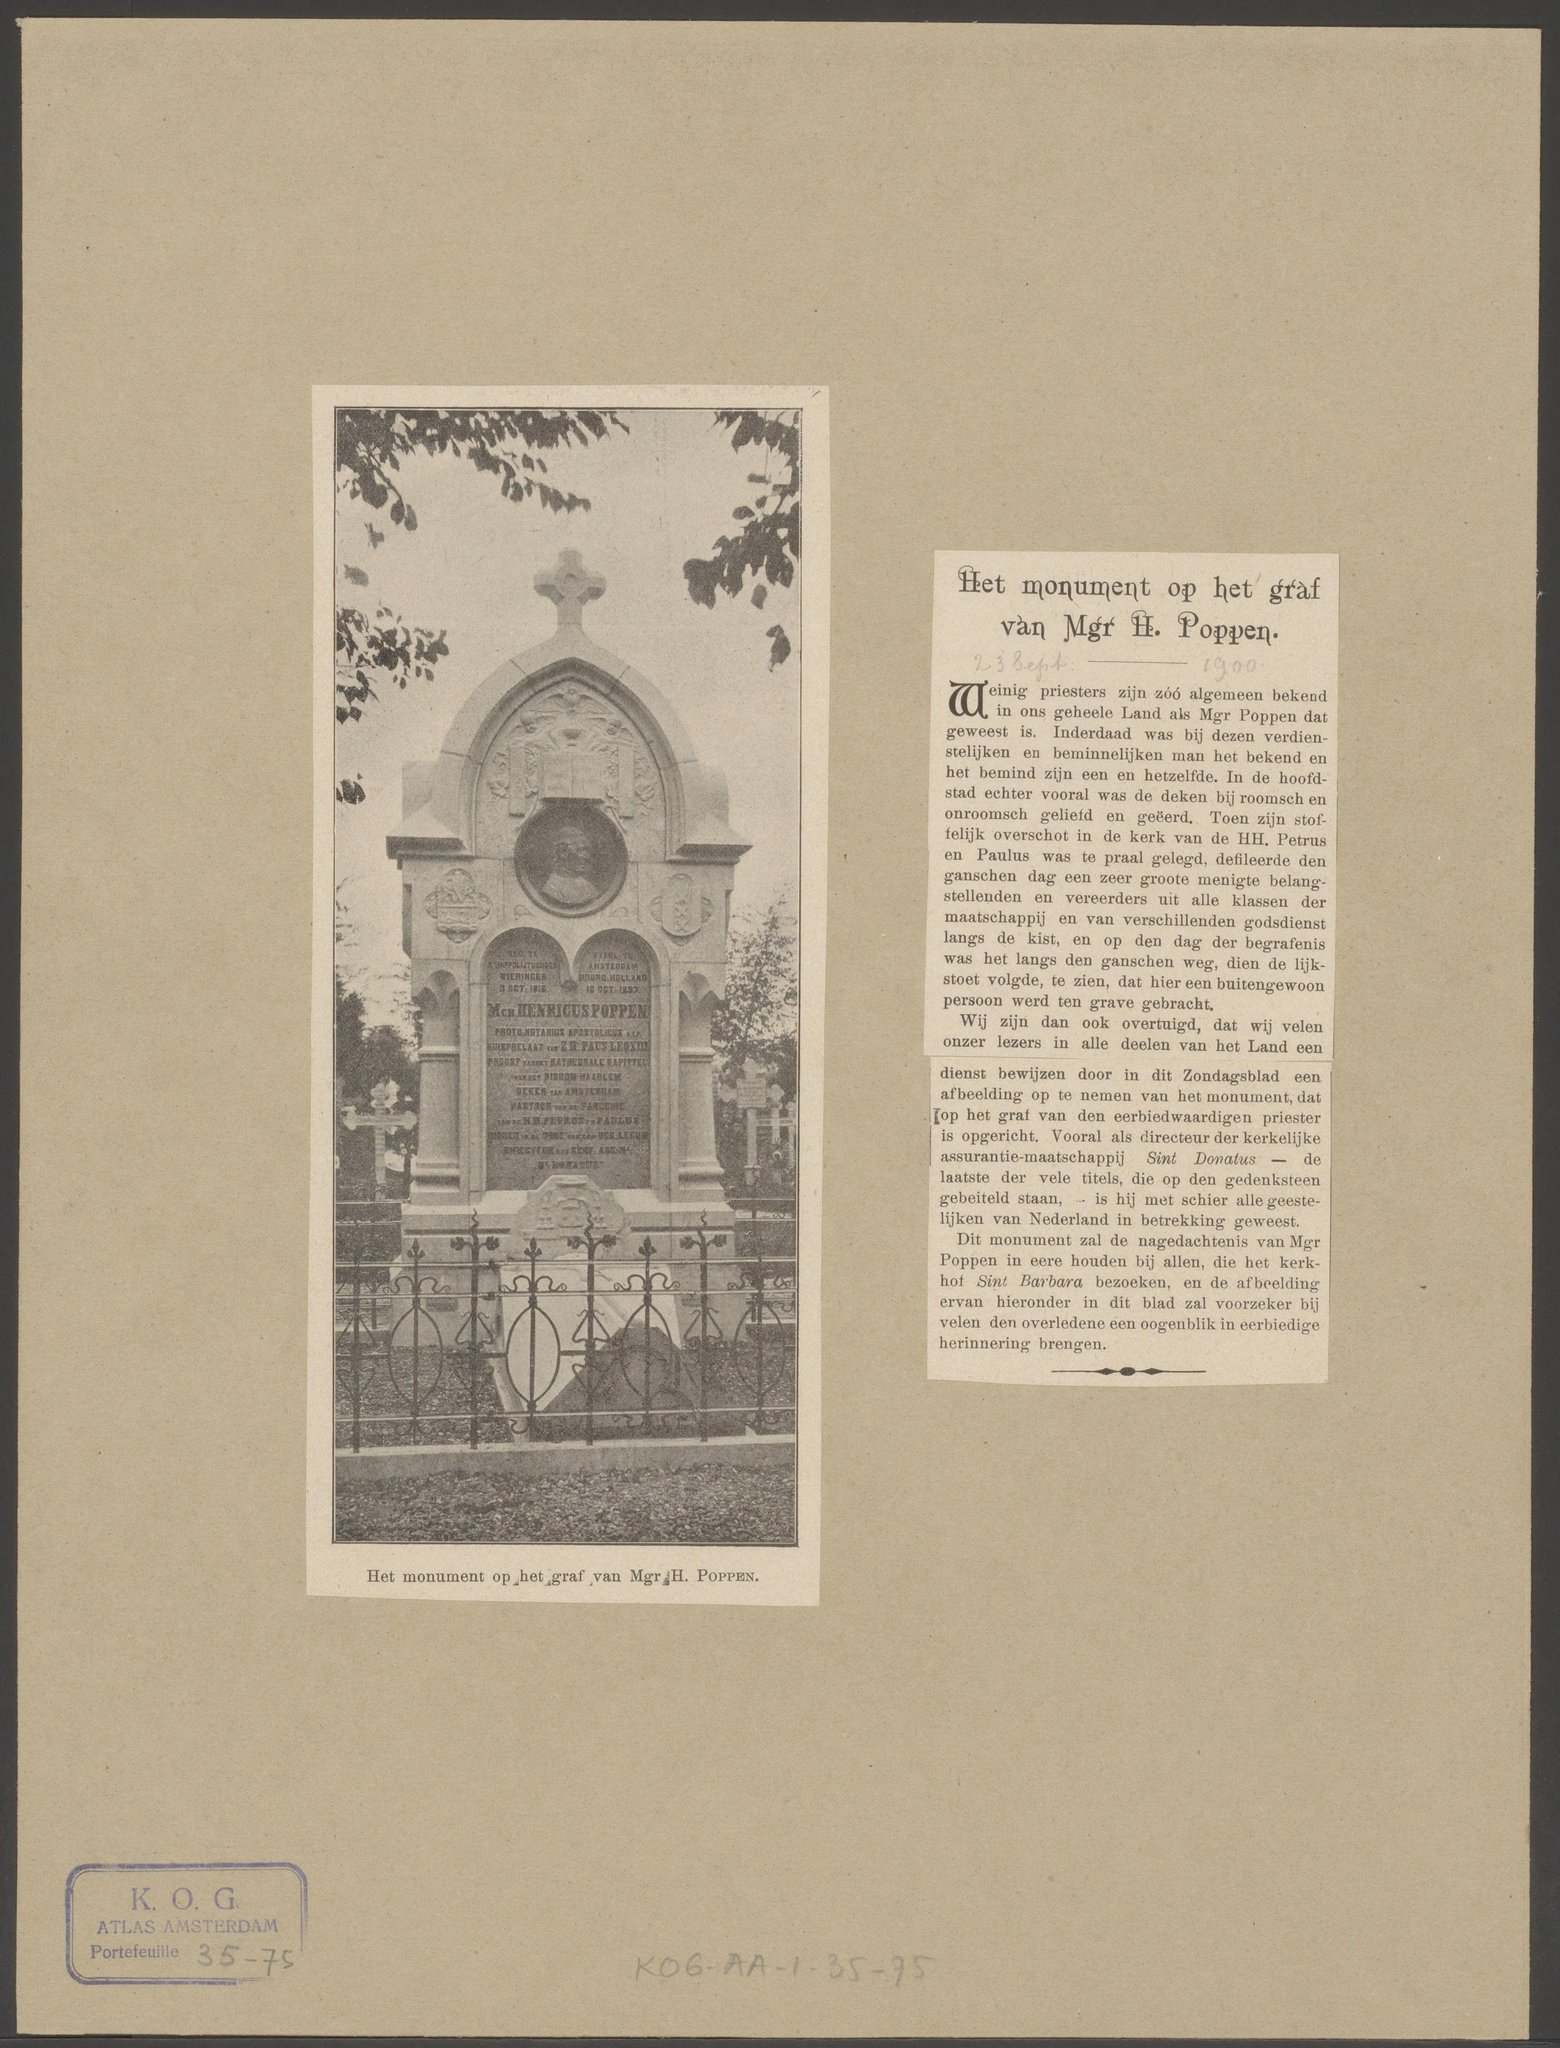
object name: newspaper clipping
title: Het monument op het graf van Mgr H. Poppen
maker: Anonymous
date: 1900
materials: paper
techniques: letterpress printing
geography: amsterdam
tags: upright gravestone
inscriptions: collector's mark: ‘35-75’ Lugt 1641b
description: Twee knipsels uit het Geïllustreerd zondagsblad voor katholieken (1900). Onderwerpsrubriek binnen de Atlas Amsterdam: R.K. Gemeenten: Herinneringen aan pastoors.